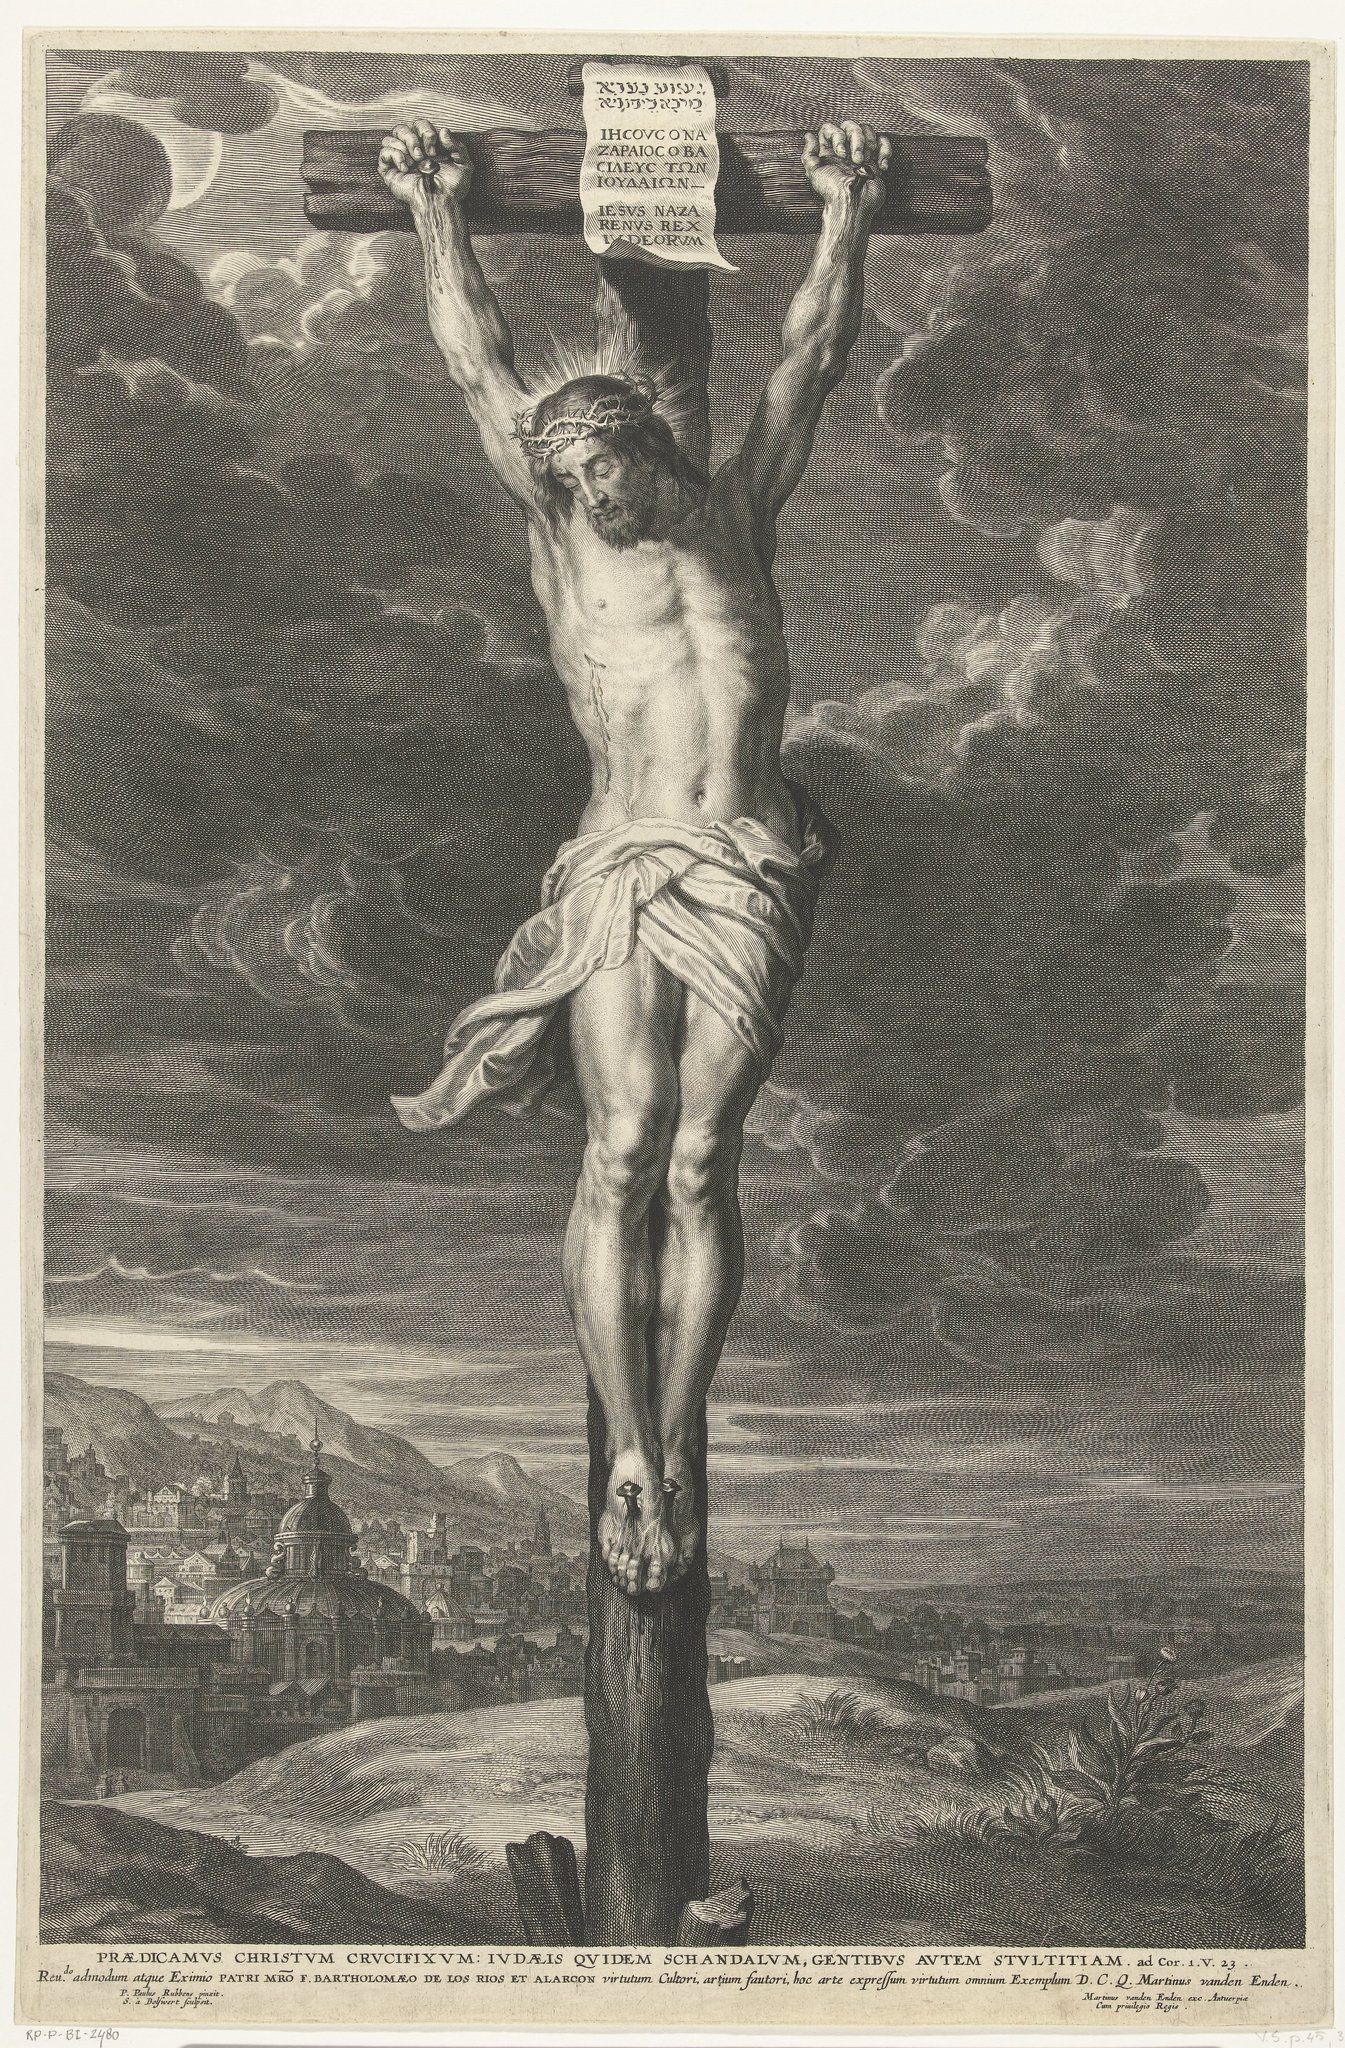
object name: print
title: Christus aan het kruis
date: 1596-1659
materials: paper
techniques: engraving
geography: antwerp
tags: christ on the cross on golgotha (alone, without bystanders)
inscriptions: collector's mark: Lugt 240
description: Prent naar schilderij van Peter Paul Rubens.